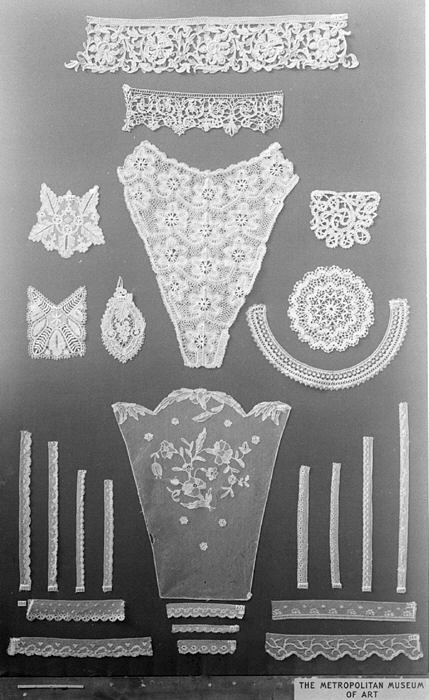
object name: plastron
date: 1801-1900